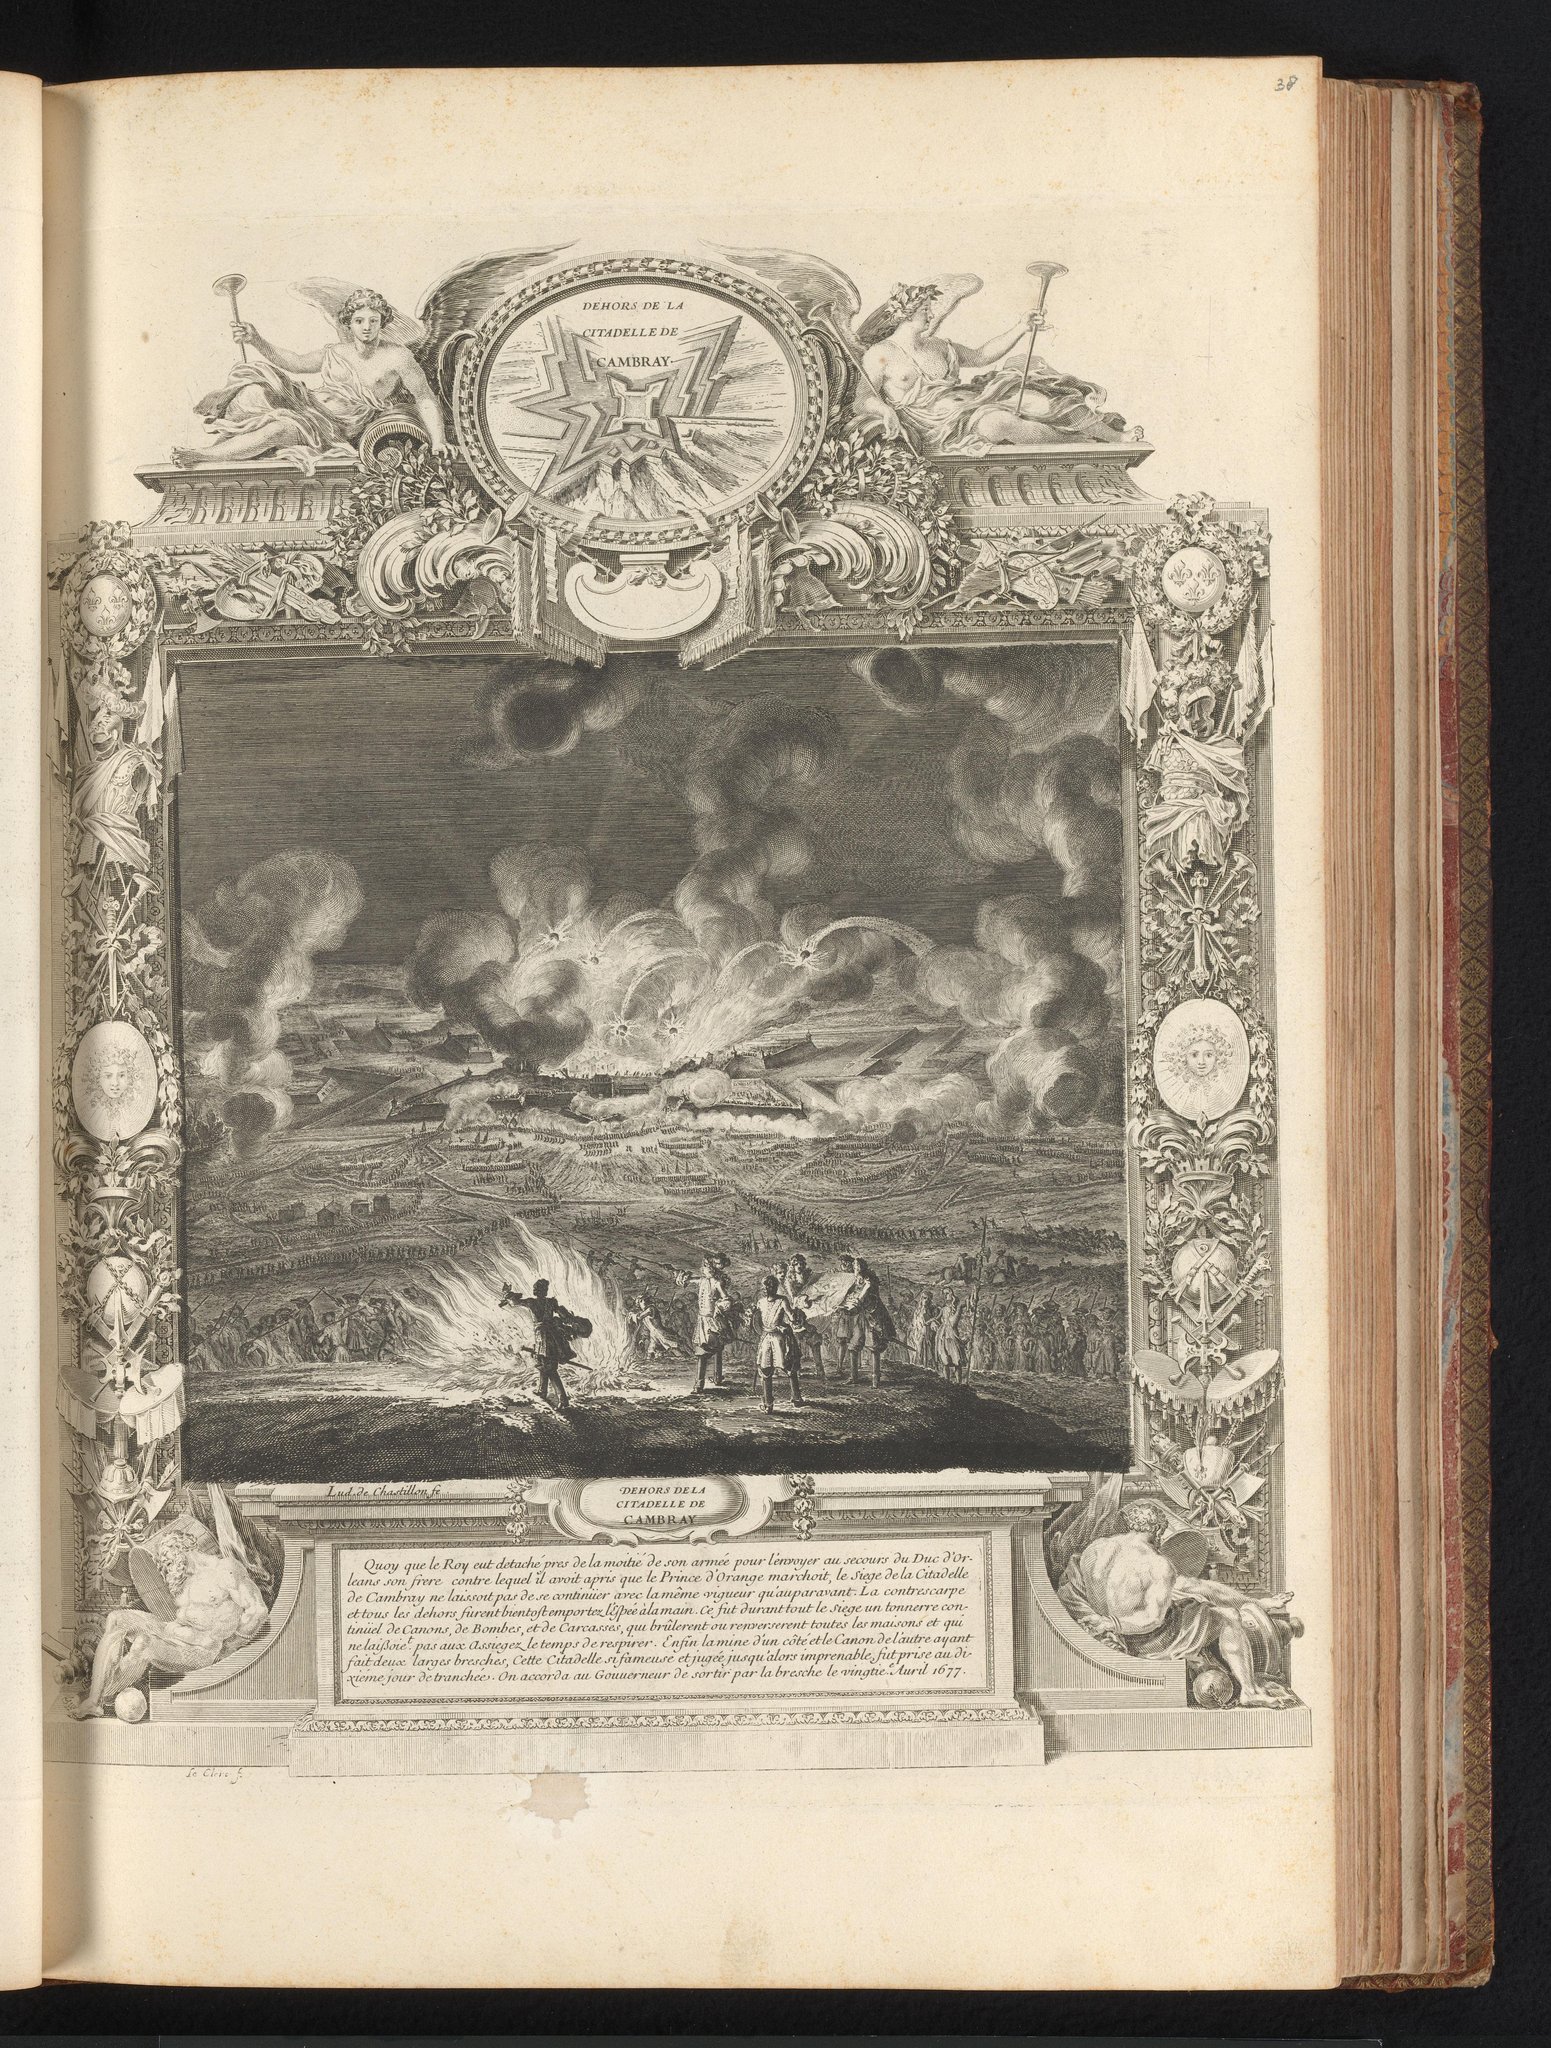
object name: print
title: Slag bij Cambrai, in een cartouche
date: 1686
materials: paper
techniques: engraving, etching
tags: the hague, william iii (prince of orange and king of england, scotland, and ireland), lodewijk xiv (koning van frankrijk), filips i (hertog van orléans), siege, position war, battle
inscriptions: watermark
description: Maakt deel uit van een serie bestaande uit 28 prenten met oorlogstaferelen in ornamentele cartouches. De prenten zijn gedrukt van twee afzonderlijke platen bestaande uit de voorstelling en de cartouche.